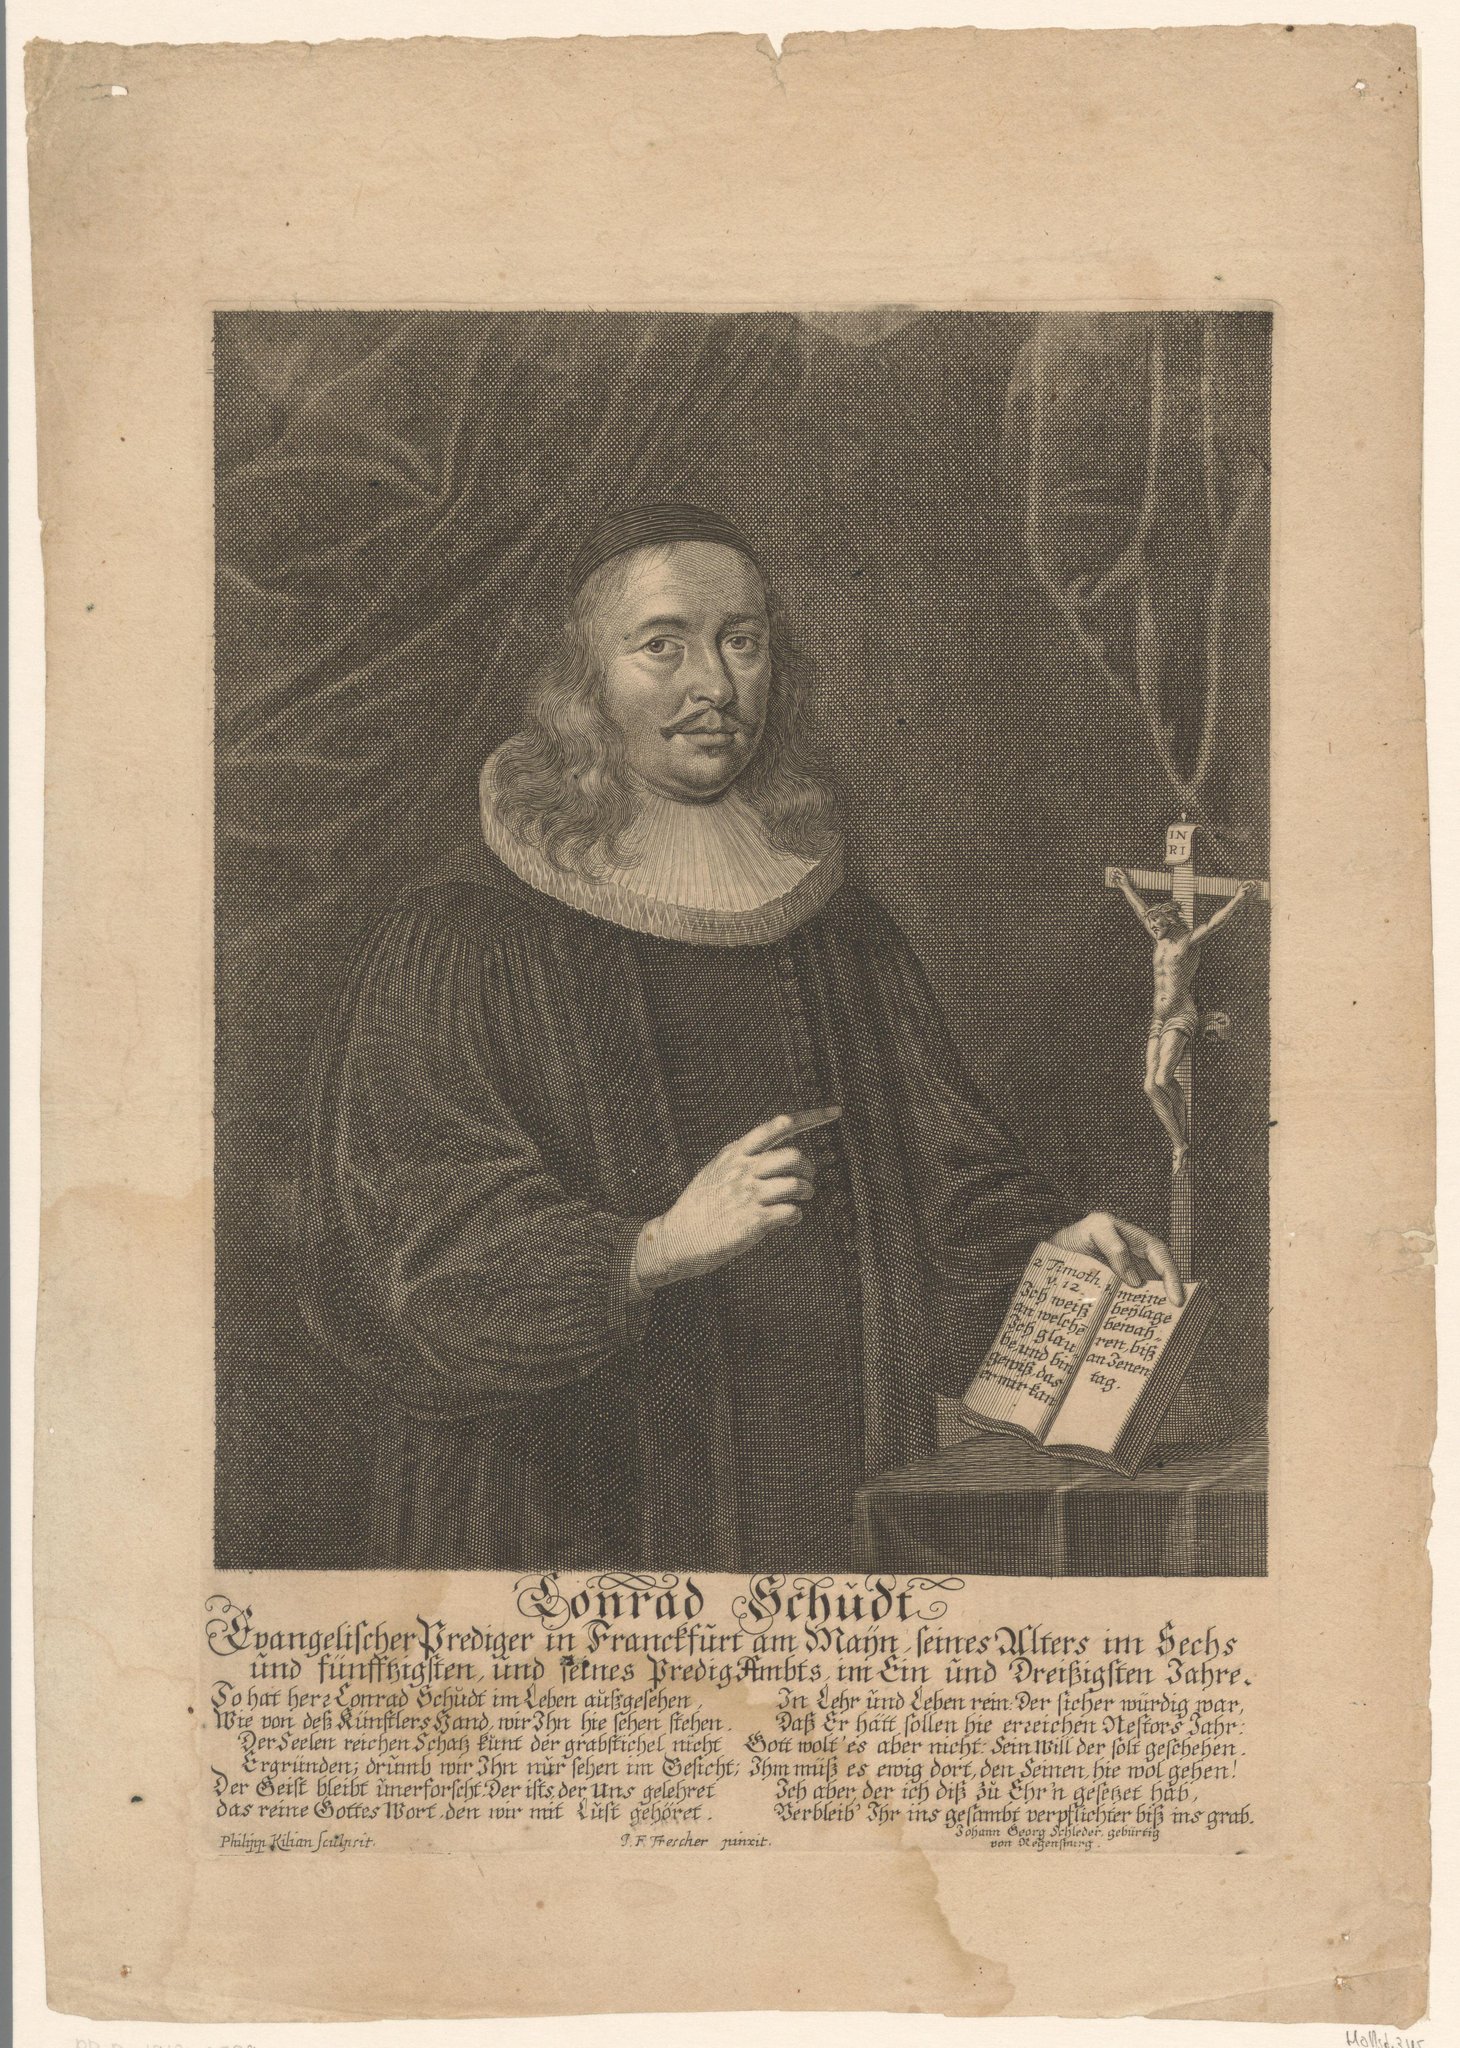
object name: print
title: Portret van Konrad Schudt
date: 1680-1693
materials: paper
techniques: engraving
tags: theologian, historical persons, crucifix ~ personal devotion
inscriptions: collector's mark: Lugt 2228